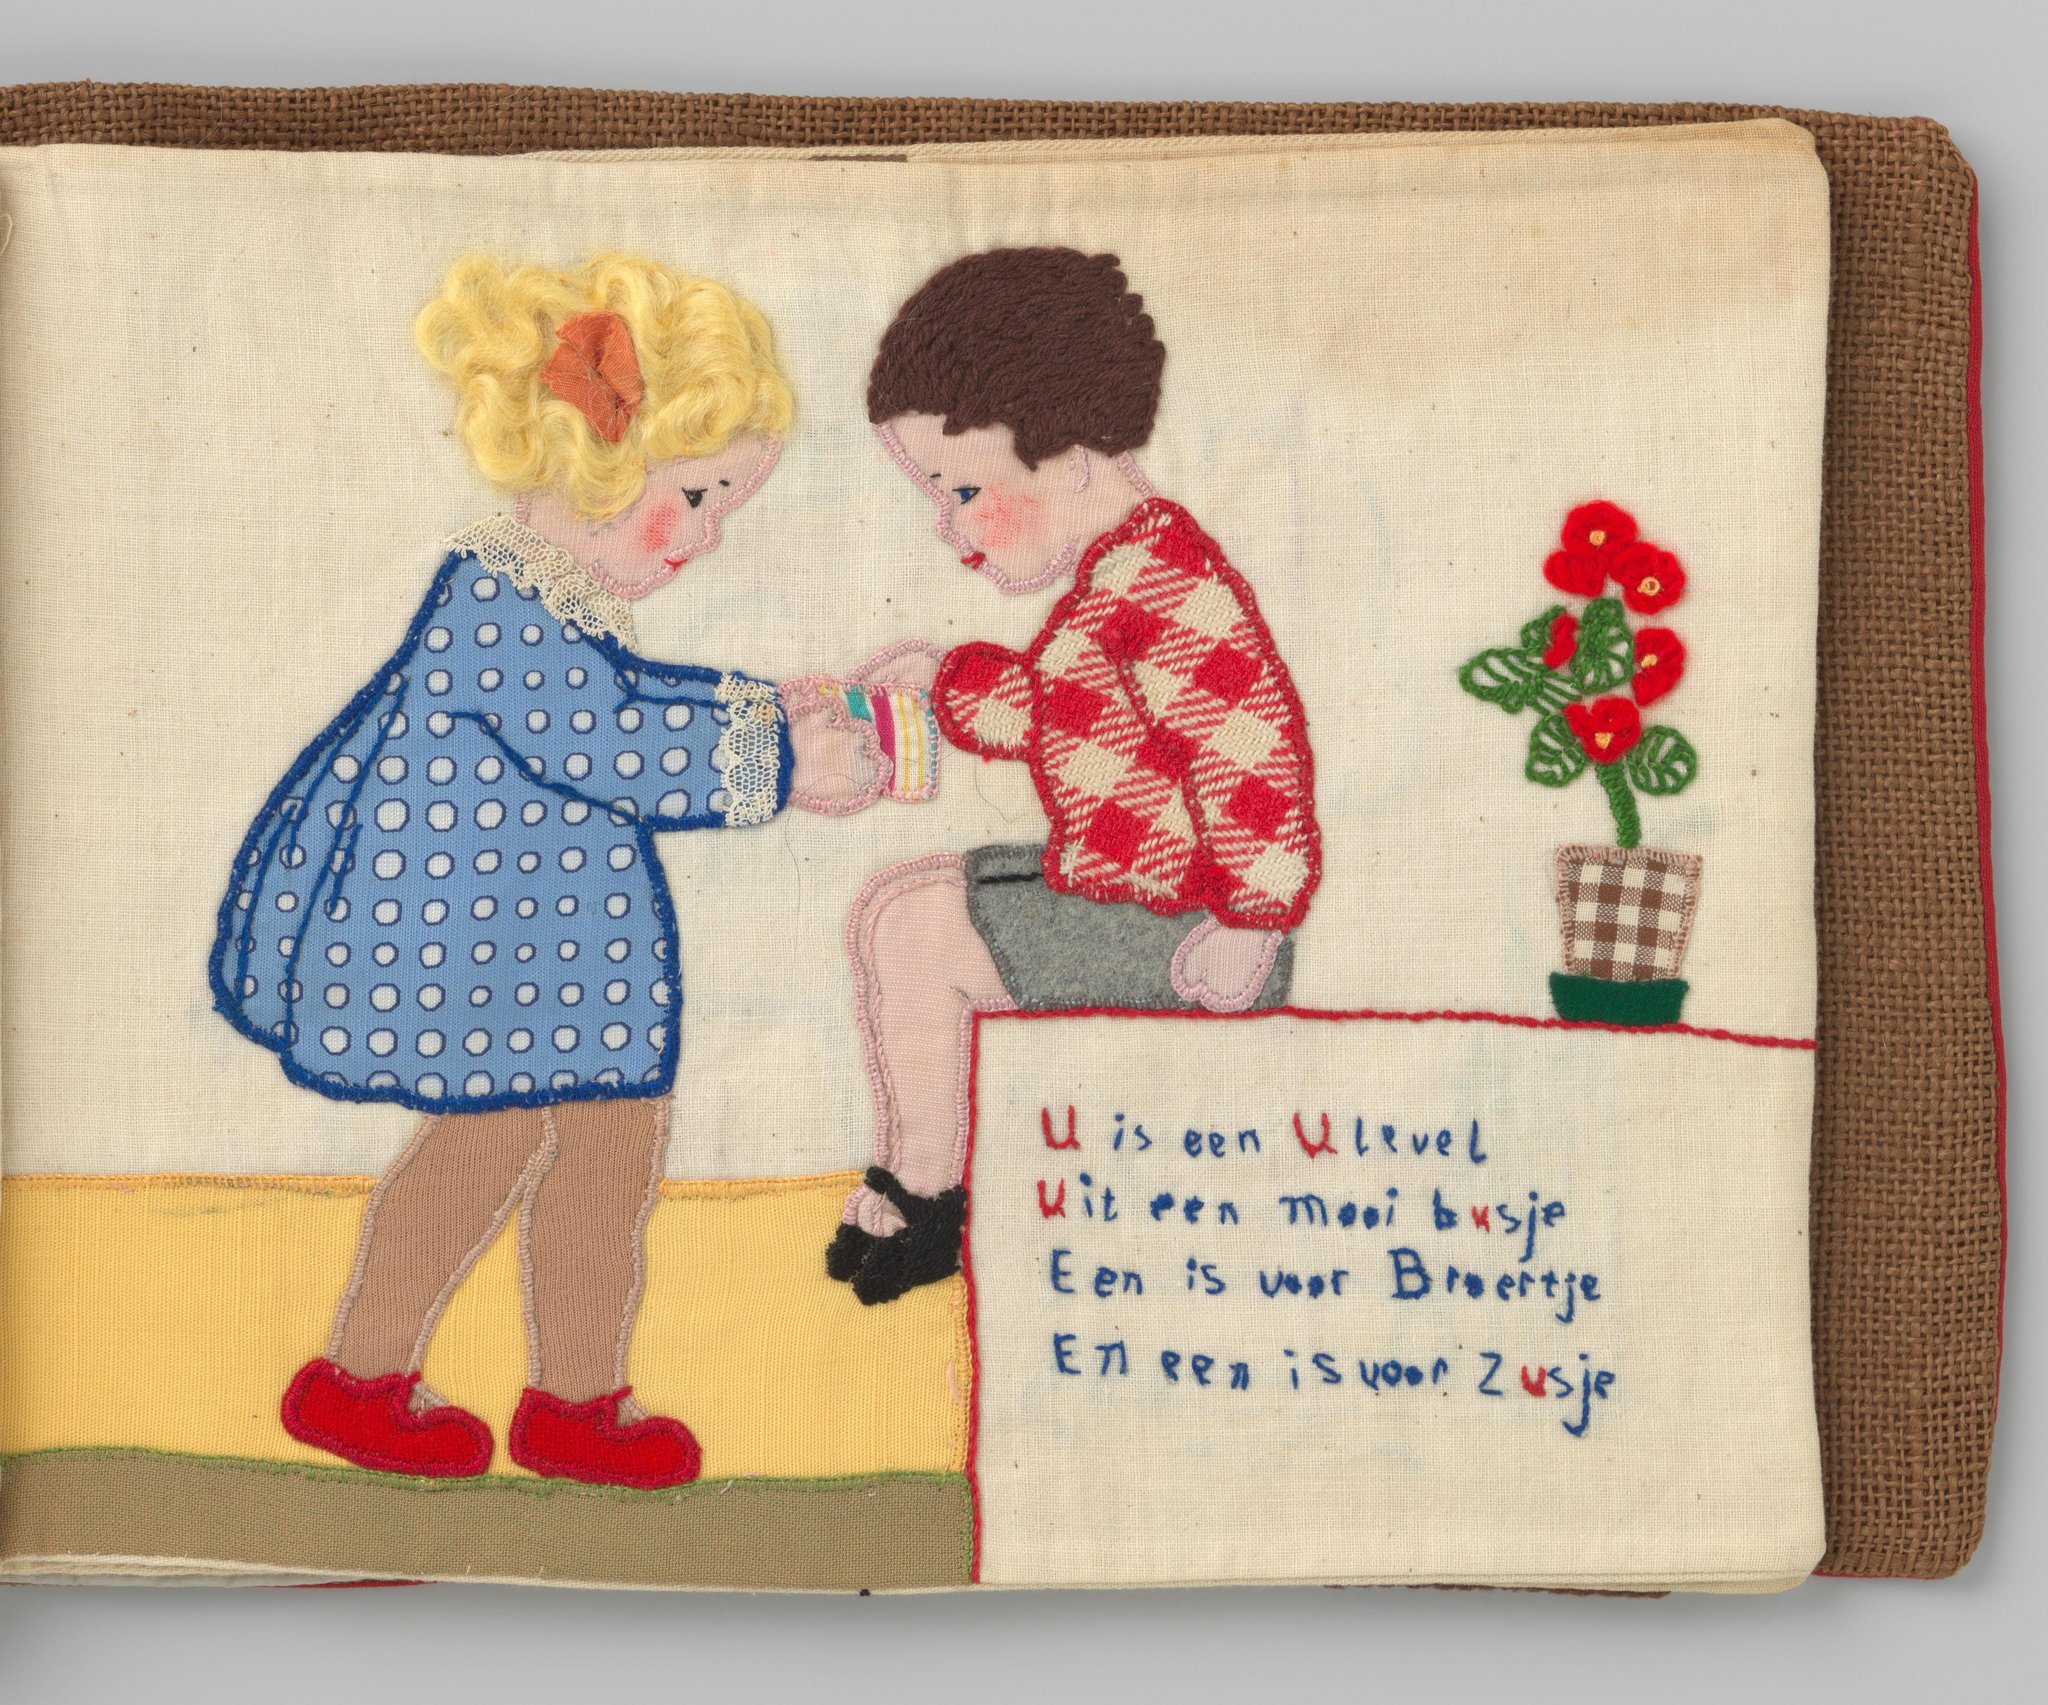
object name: blad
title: U is een Ulevel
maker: miesje geertruida maria petronella aalbersberg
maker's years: 1915-1997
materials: cotton, textile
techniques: appliqué, embroidered, stitch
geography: brastagi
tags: reading, book in which illustrations are essential, letters, alphabet, script, internment camp, nursery school (+ teaching aids), (other forms of) needlework, e.g.: crocheting, knitting, embroidering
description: In het geheim gemaakt kinderboek in textiel vrij naar A is een Aapje van Rie Cramer. Het werd gezamenlijk gemaakt door de vrouwelijke gevangenen van het Japanse interneringskamp Brastagi, een oude plantage in Noord-Sumatra 60 kilometer ten zuiden van Medan aan de weg naar het Toba-meer, tijdens de Tweede Wereldoorlog ter gelegenheid van de vijfde verjaardag van Pem Hagers, de dochter van Miesje Hagers-Aalbersberg die de ontwerptekeningen en sjablonen had gemaakt.